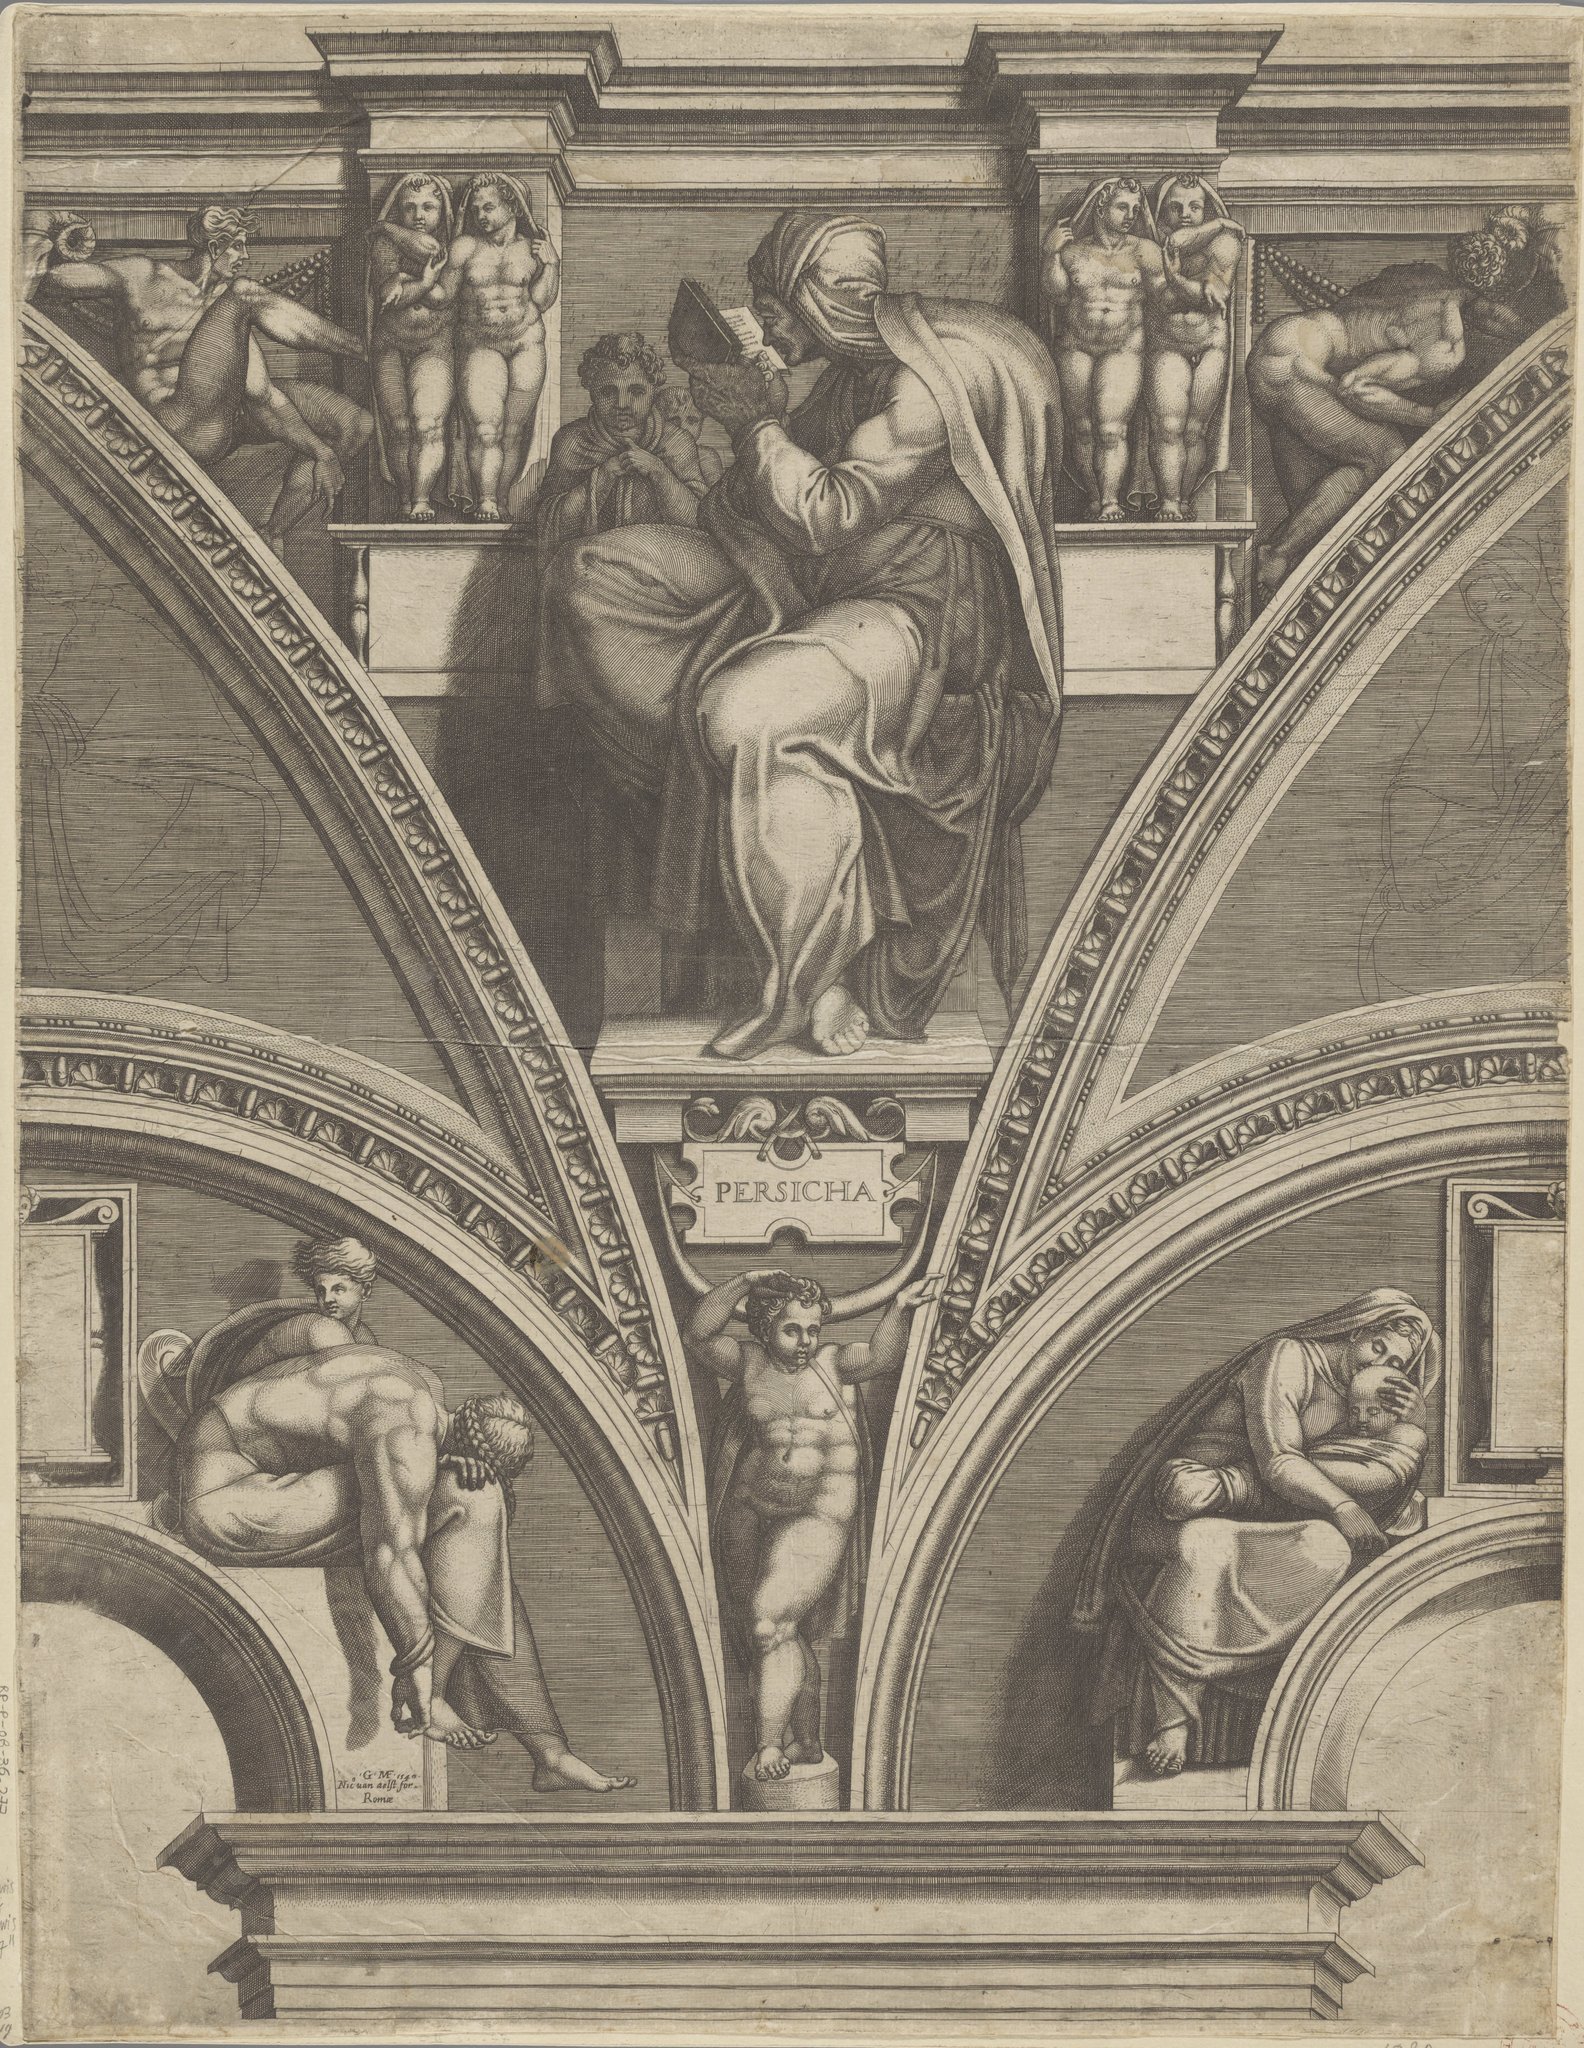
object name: print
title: Schilderingen in de lunetten boven de ramen in de Sixtijnse Kapel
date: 1540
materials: paper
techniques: engraving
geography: vatican city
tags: sibyls, persian sibyl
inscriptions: collector's mark: Lugt 240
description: Prent uit een reeks van 6 prenten naar de schilderingen in de lunetten boven de ramen in de Sixtijnse Kapel door Michelangelo.